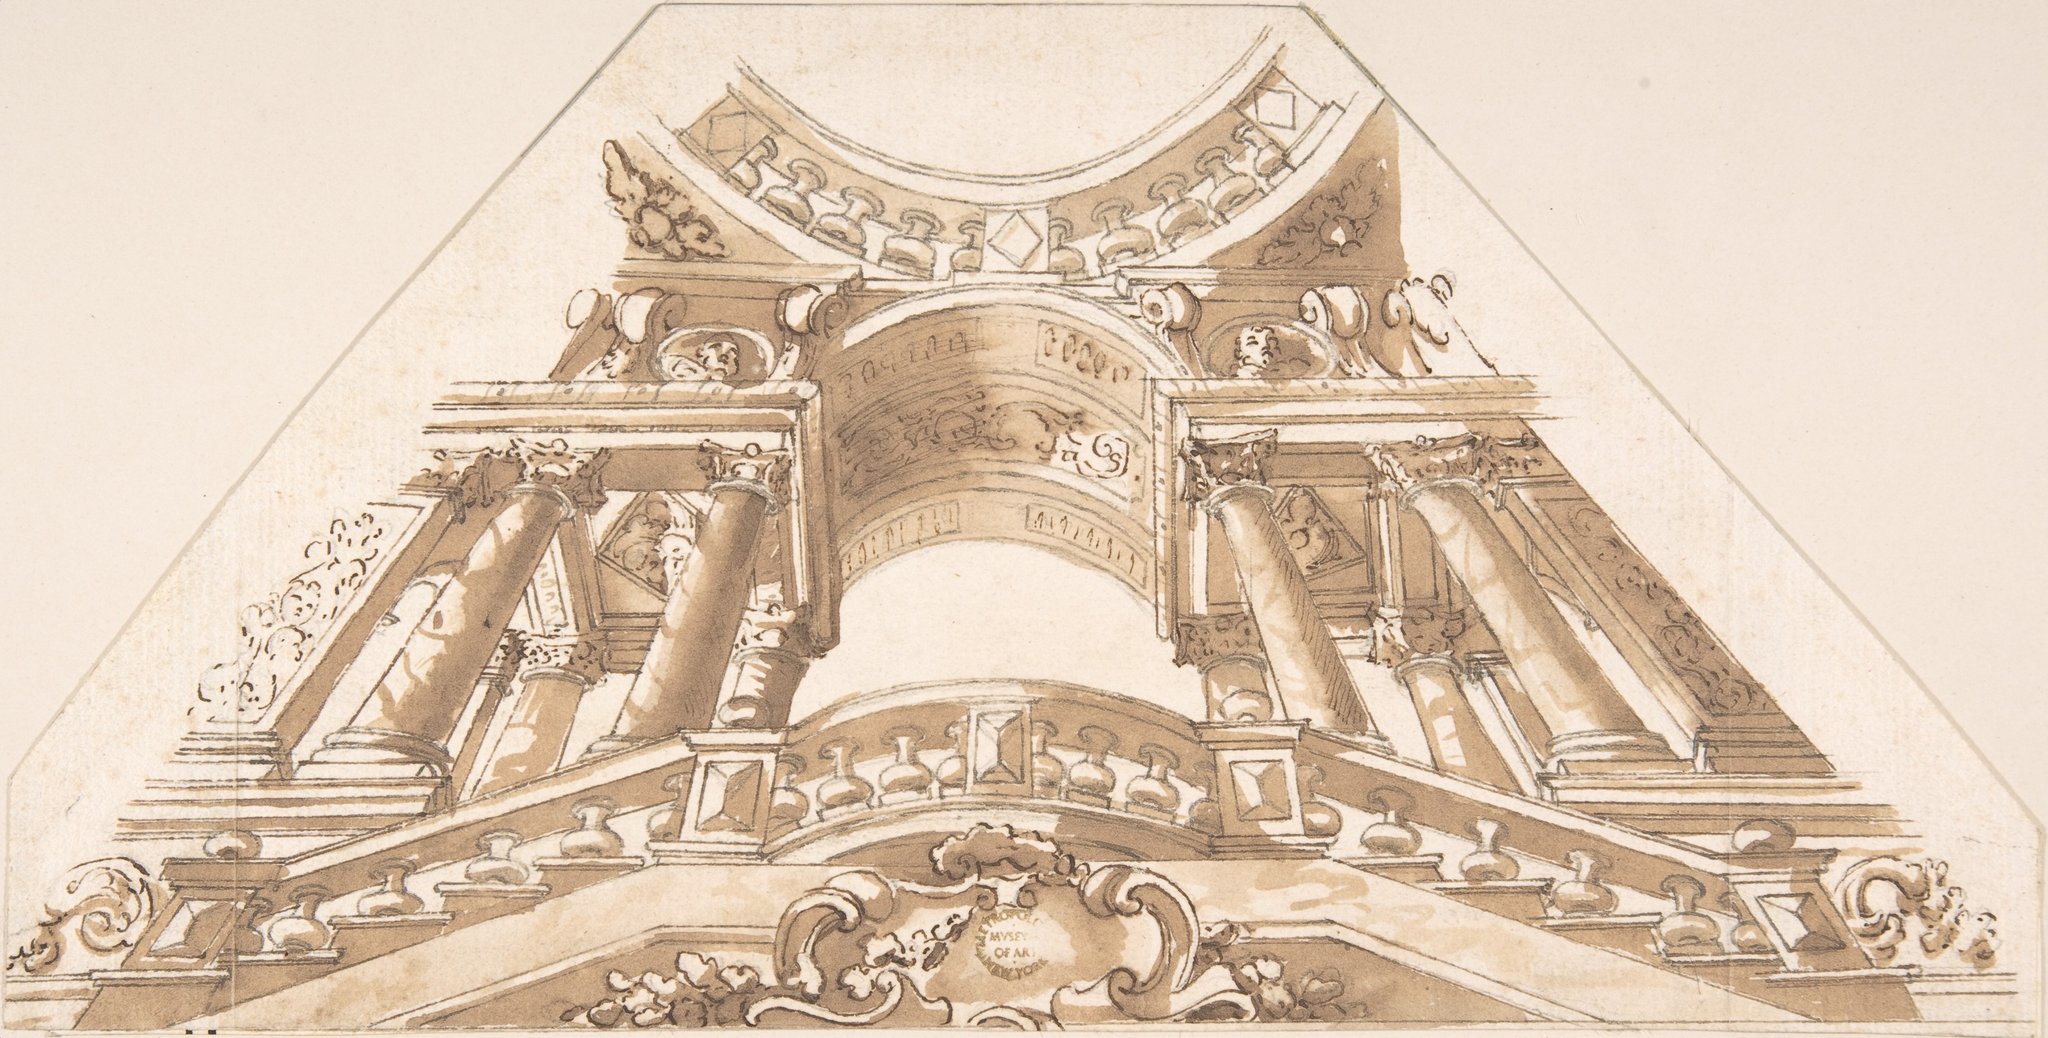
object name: drawing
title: Sketch for Ceiling Panel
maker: anonymous, italian, 16th century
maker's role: artist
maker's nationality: italian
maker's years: 1550-1600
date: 1501-1600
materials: ink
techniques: pen, wash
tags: architecture